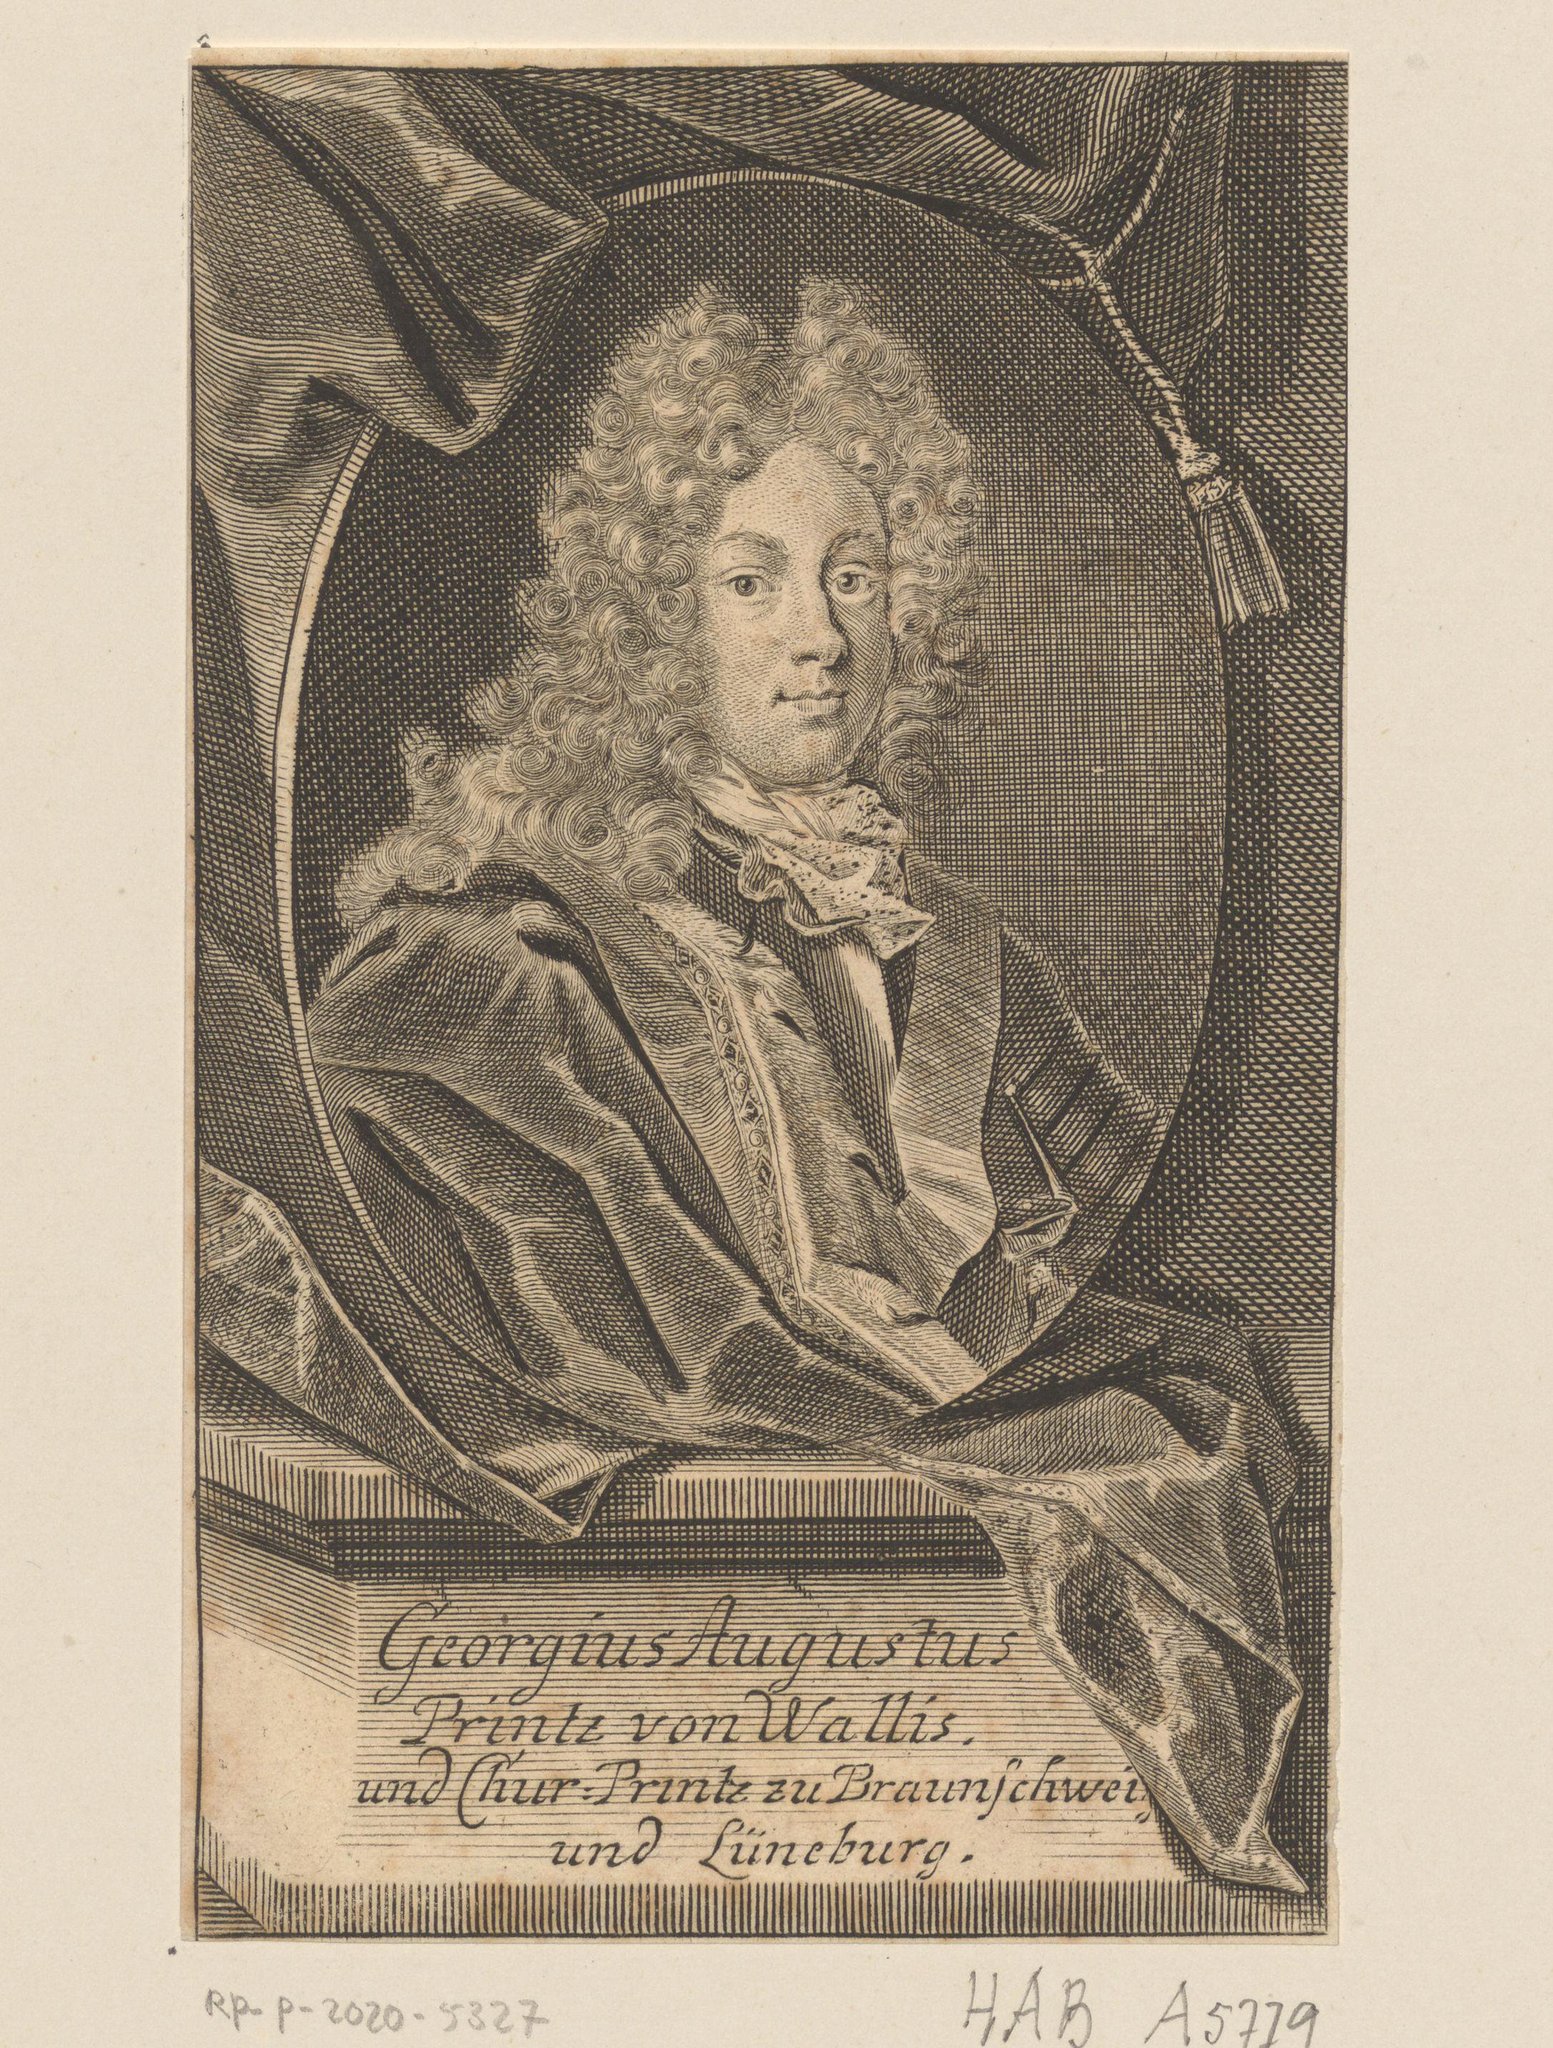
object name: print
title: Portret van George II, prins van Groot-Brittannië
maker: martin bernigeroth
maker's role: print maker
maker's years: 1670-1733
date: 1690-1714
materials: paper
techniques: engraving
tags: historical persons, king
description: Prent mogelijk uit: Die Europäische Fama, Welche den gegenwärtigen Zustand der vornehmsten Höfe entdecket. S.l.s.n., 1714, dl. 163.